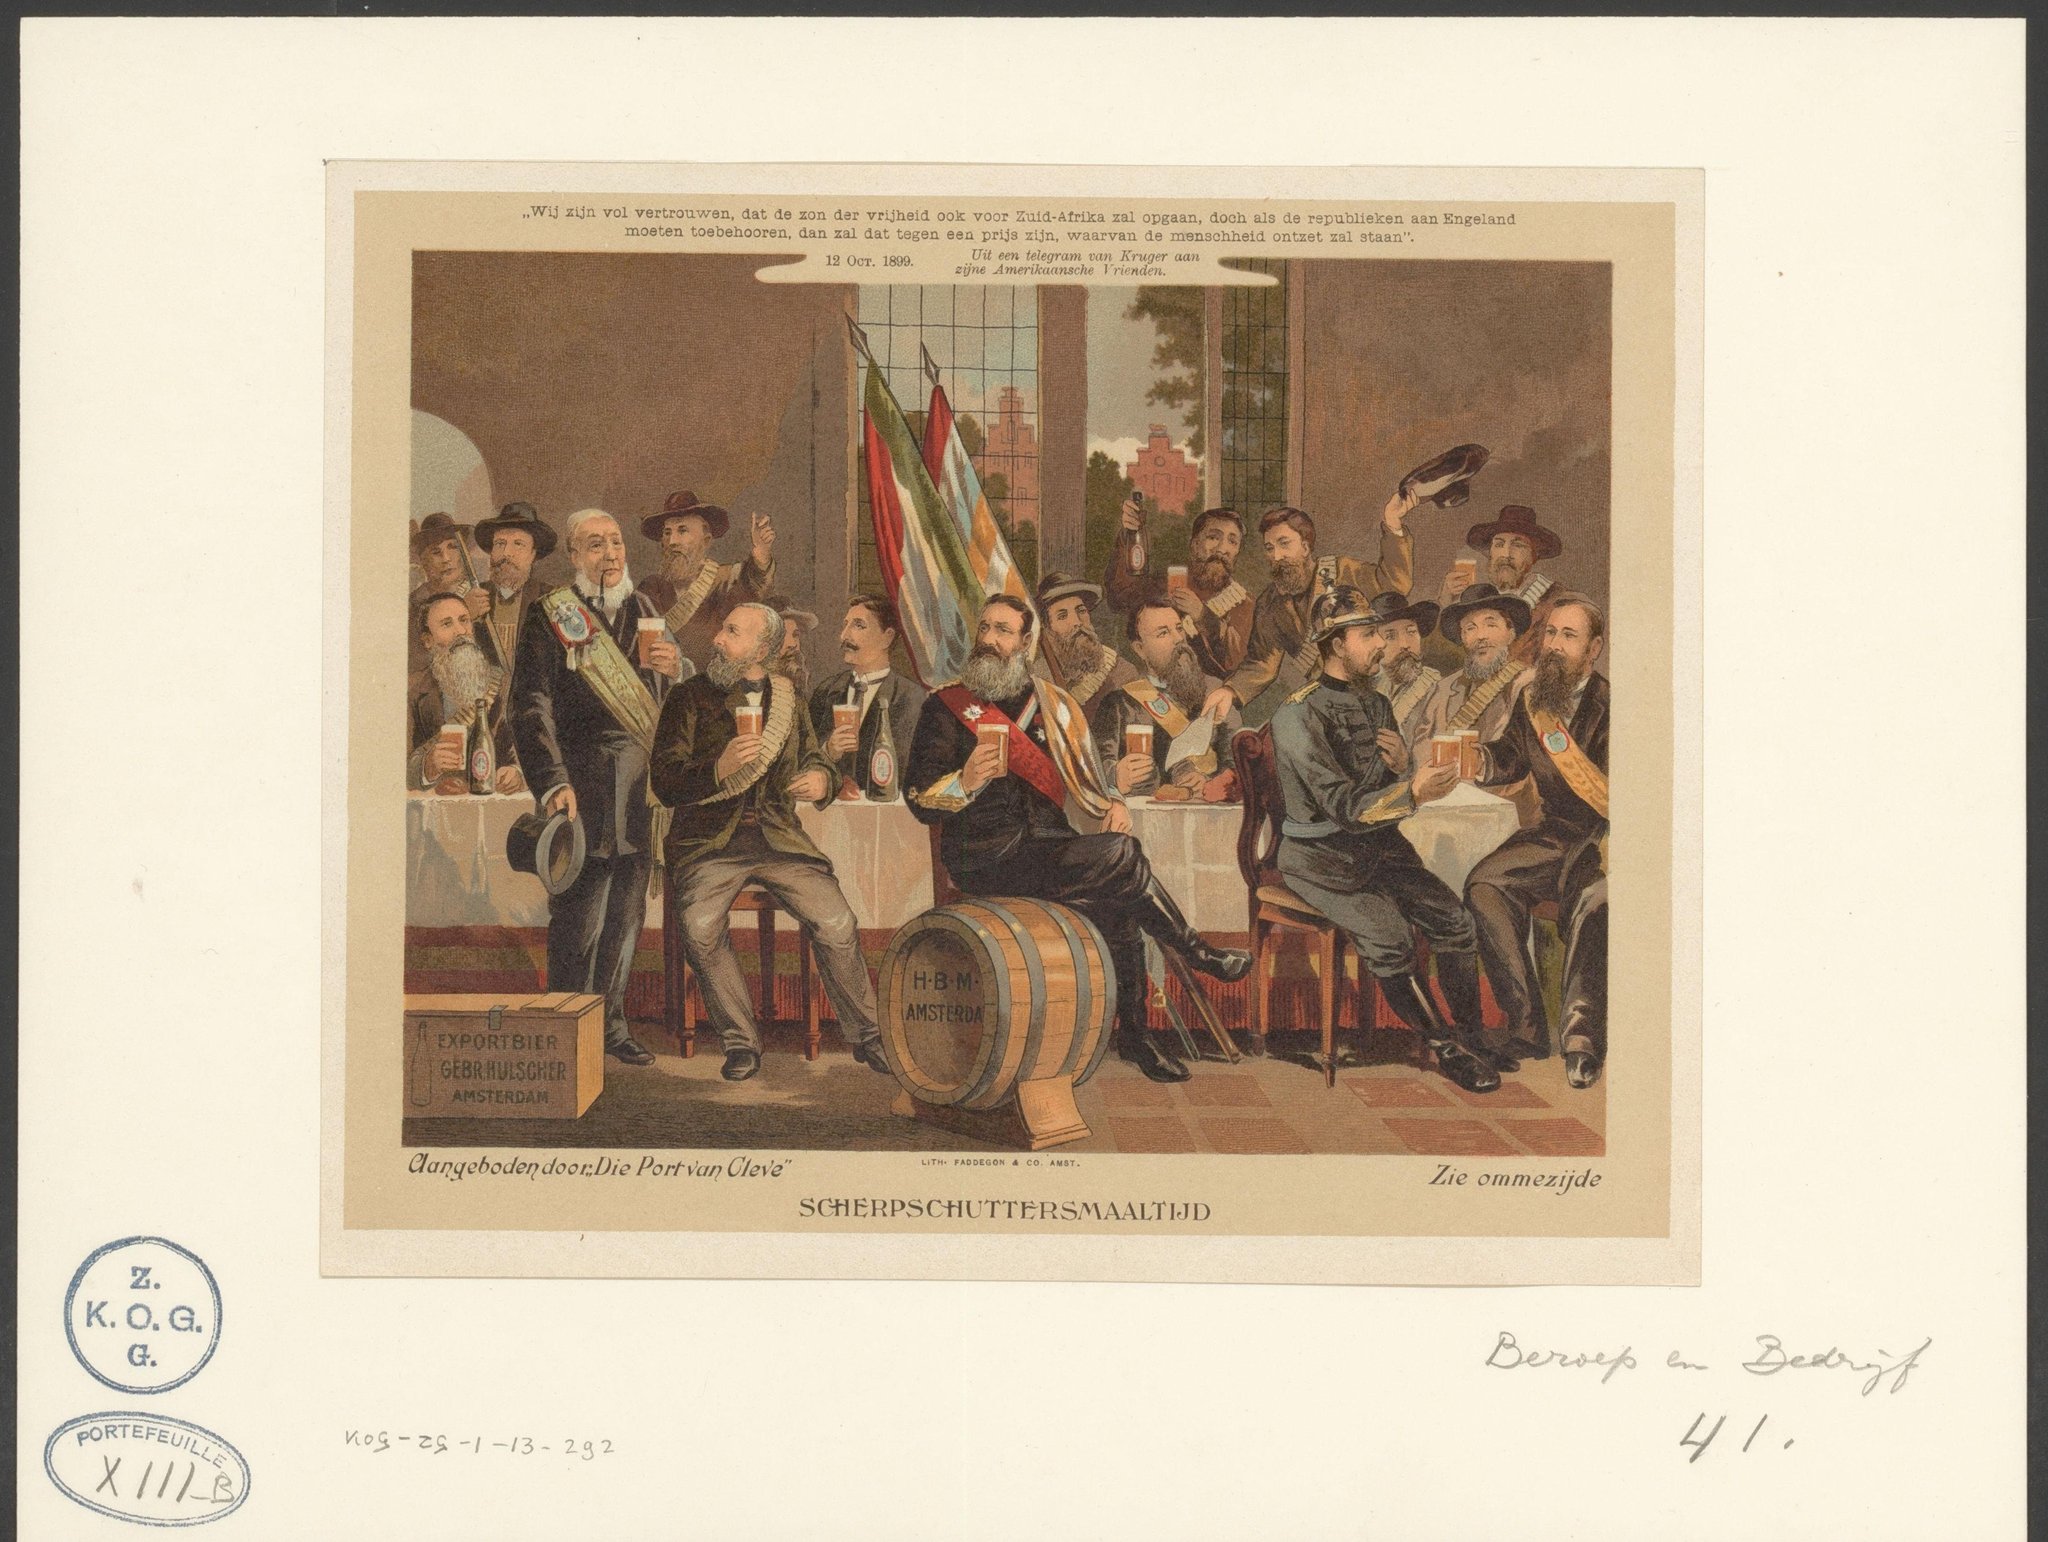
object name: print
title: Scherpschuttersmaaltijd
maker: Anonymous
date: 1899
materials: paper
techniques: printing block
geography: amsterdam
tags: glass of beer, festivities, flag, colours (as symbol of the state, etc.)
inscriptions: collector's mark: Lugt 1641, stamp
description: Scherpschuttersmaaltijd in die Poort van Cleve. Bovenaan een telegram van Paul Kruger aan Amerika, verzonden op 12 oktober 1899. Onderwerpsrubrieken binnen de Atlas Zeden en Gewoonten: Handel, Nijverheid en Verkeer, Beroep en bedrijf, Mannelijk, Eet- en drinkwaren.